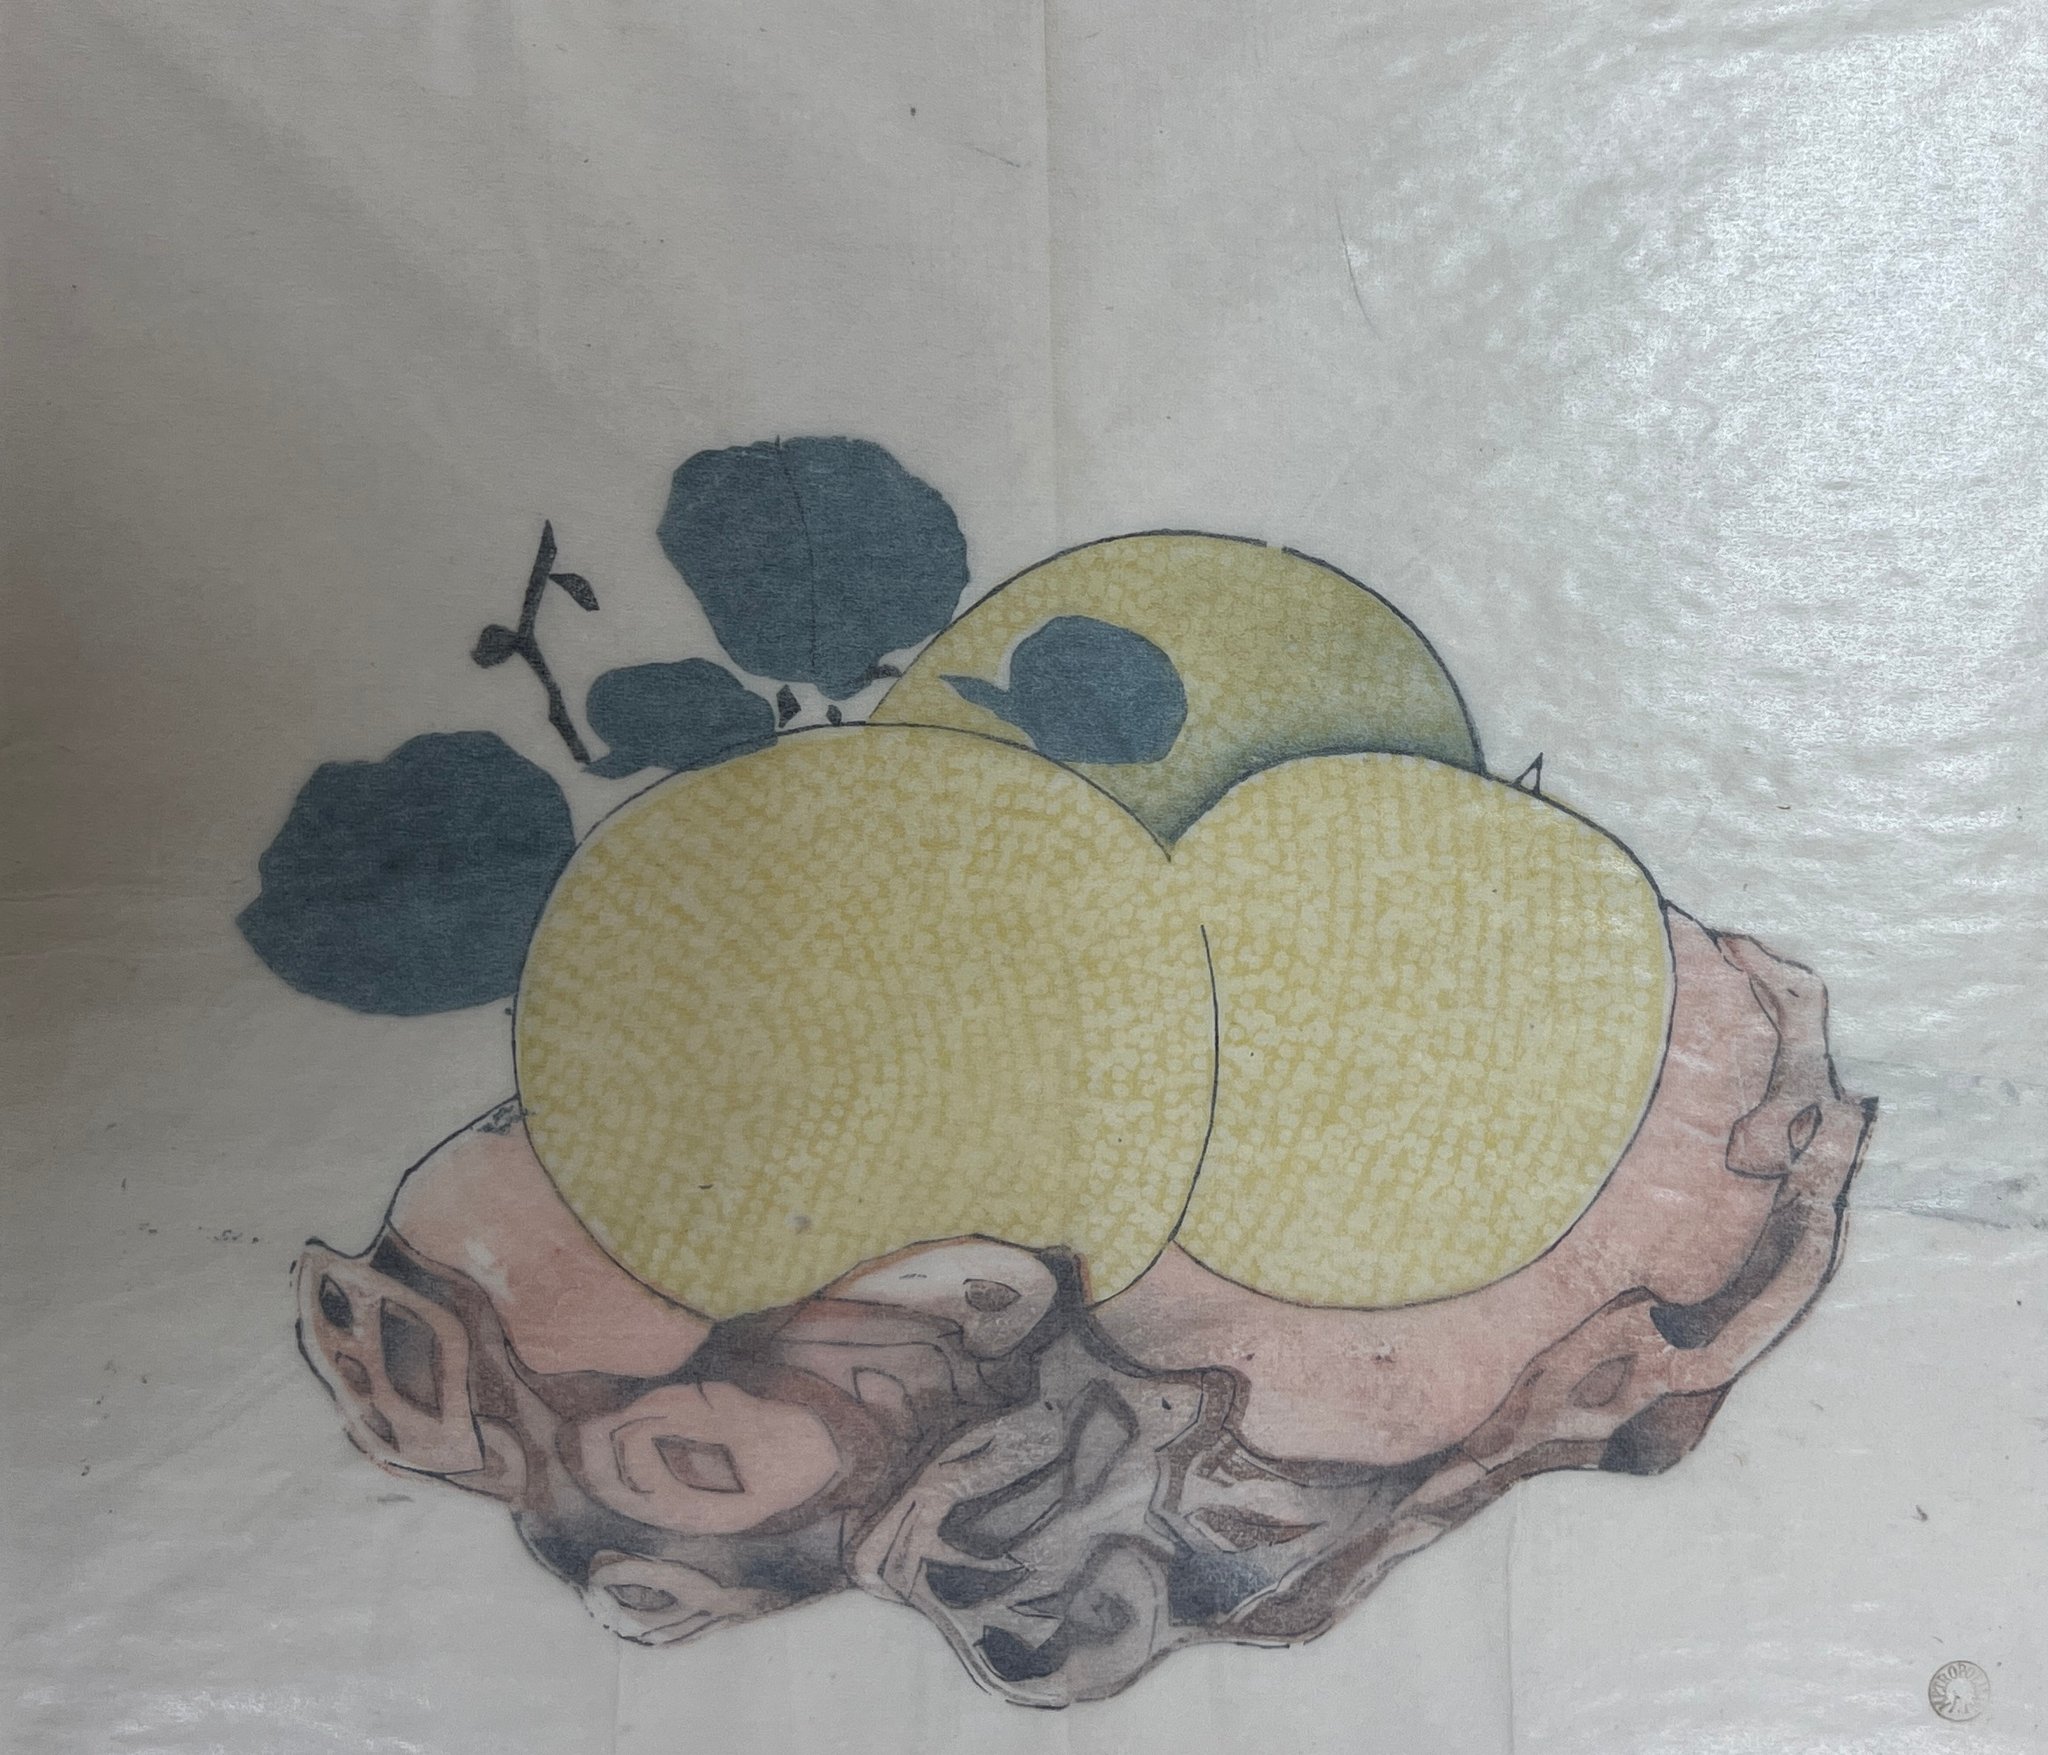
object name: print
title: Page from Ten Bamboo Studio Manual of Painting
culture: chinese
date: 1736-1795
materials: ink, paper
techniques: polychrome, woodblock print